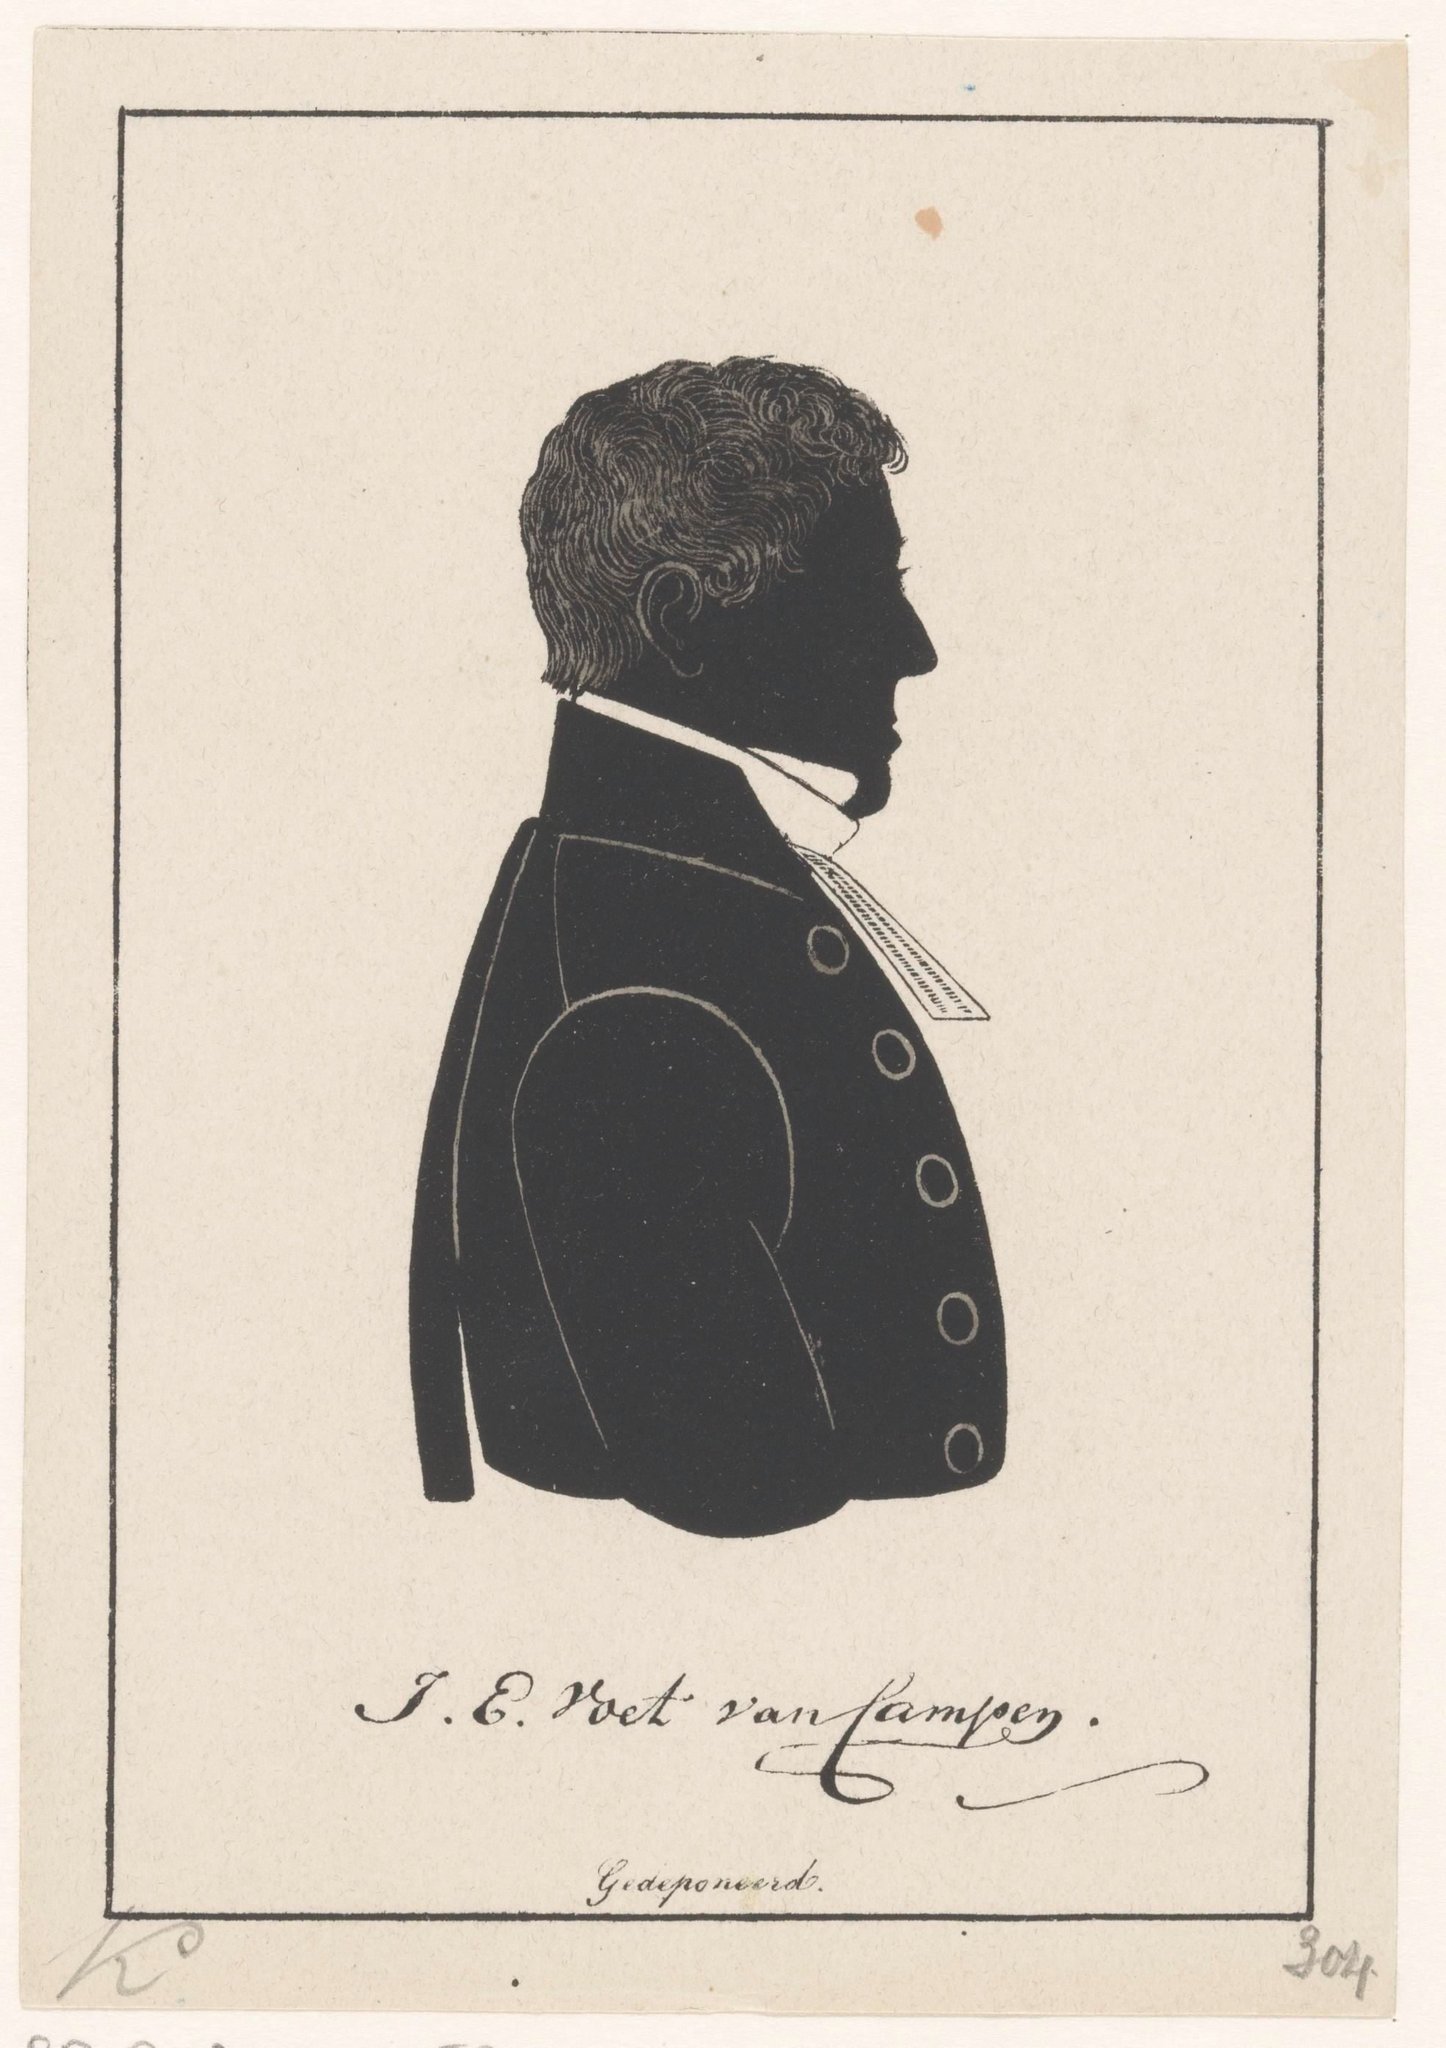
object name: print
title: Silhouetportret van Johannes Eusebius Voet van Campen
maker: pieter barbiers (iv)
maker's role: painter, print maker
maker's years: 1798-1848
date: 1809-1848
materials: paper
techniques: hand coloring, lithograph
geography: netherlands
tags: leiden, print maker, draughtsman, historical persons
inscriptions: : ‘Gedeponeerd.’, collector's mark: Lugt 2228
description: Onder het portret de signatuur van de geportretteerde.